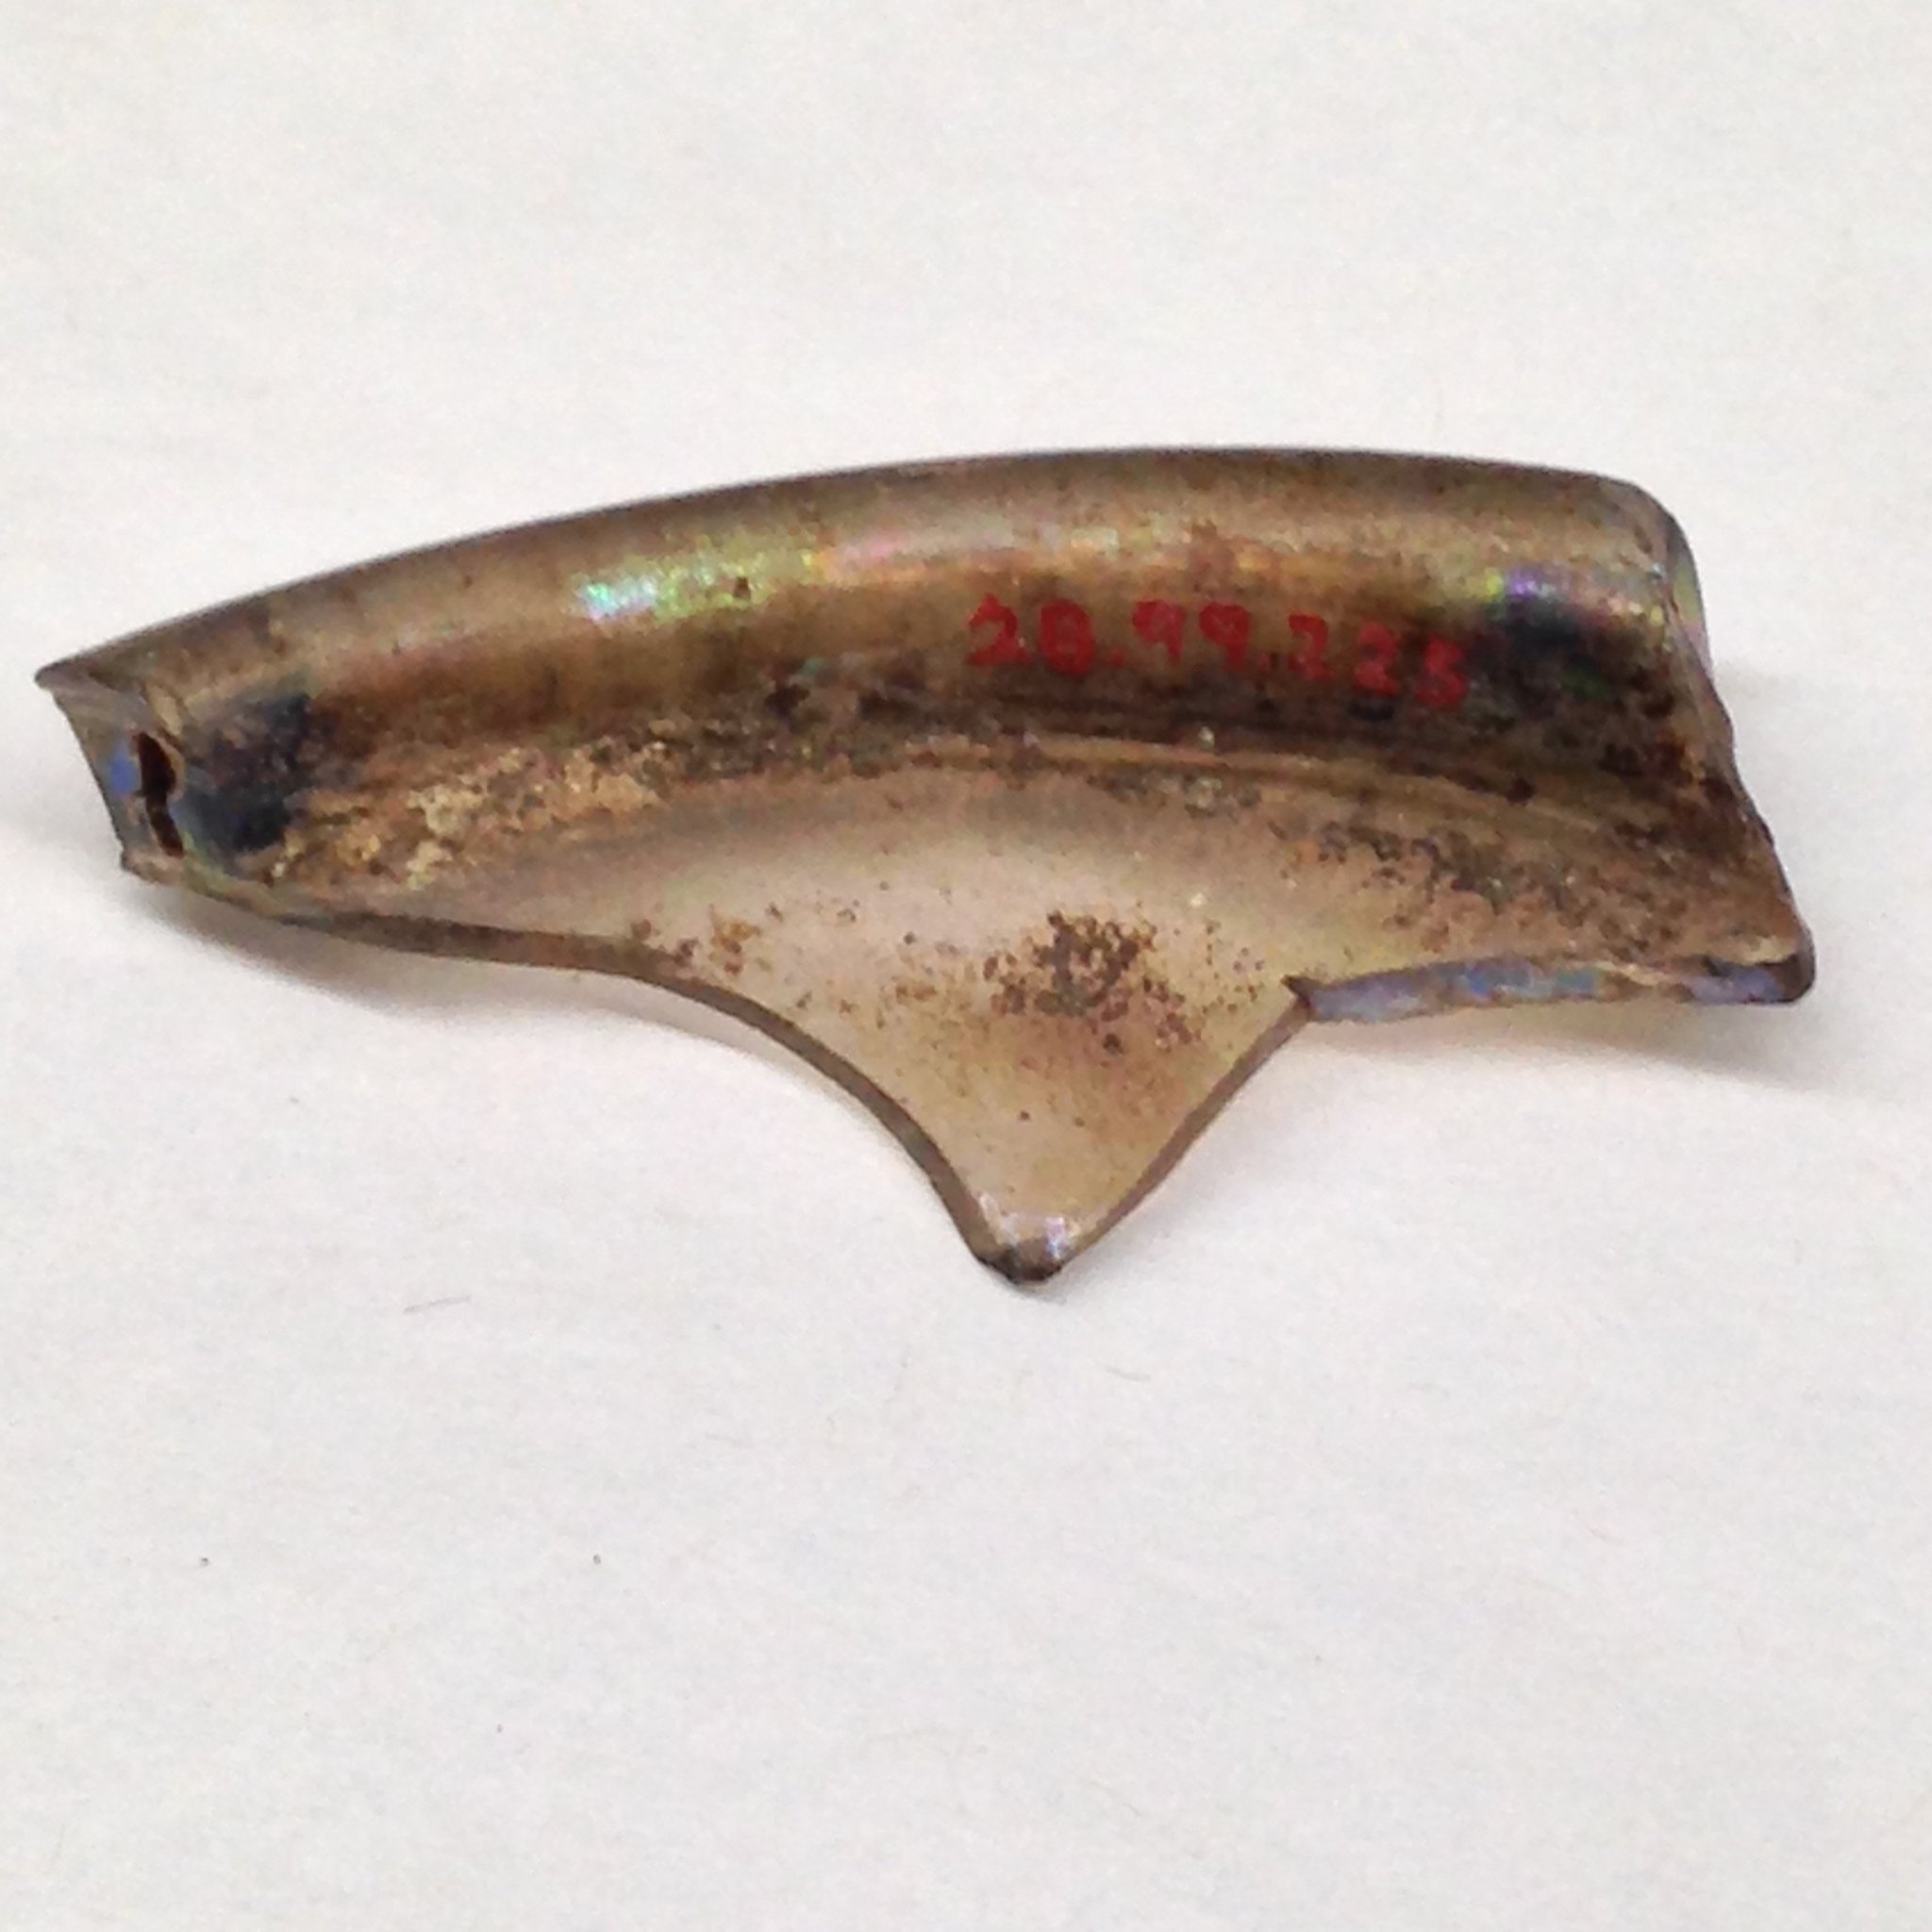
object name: fragment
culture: european or middle eastern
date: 1150-1250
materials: ceramic, glass